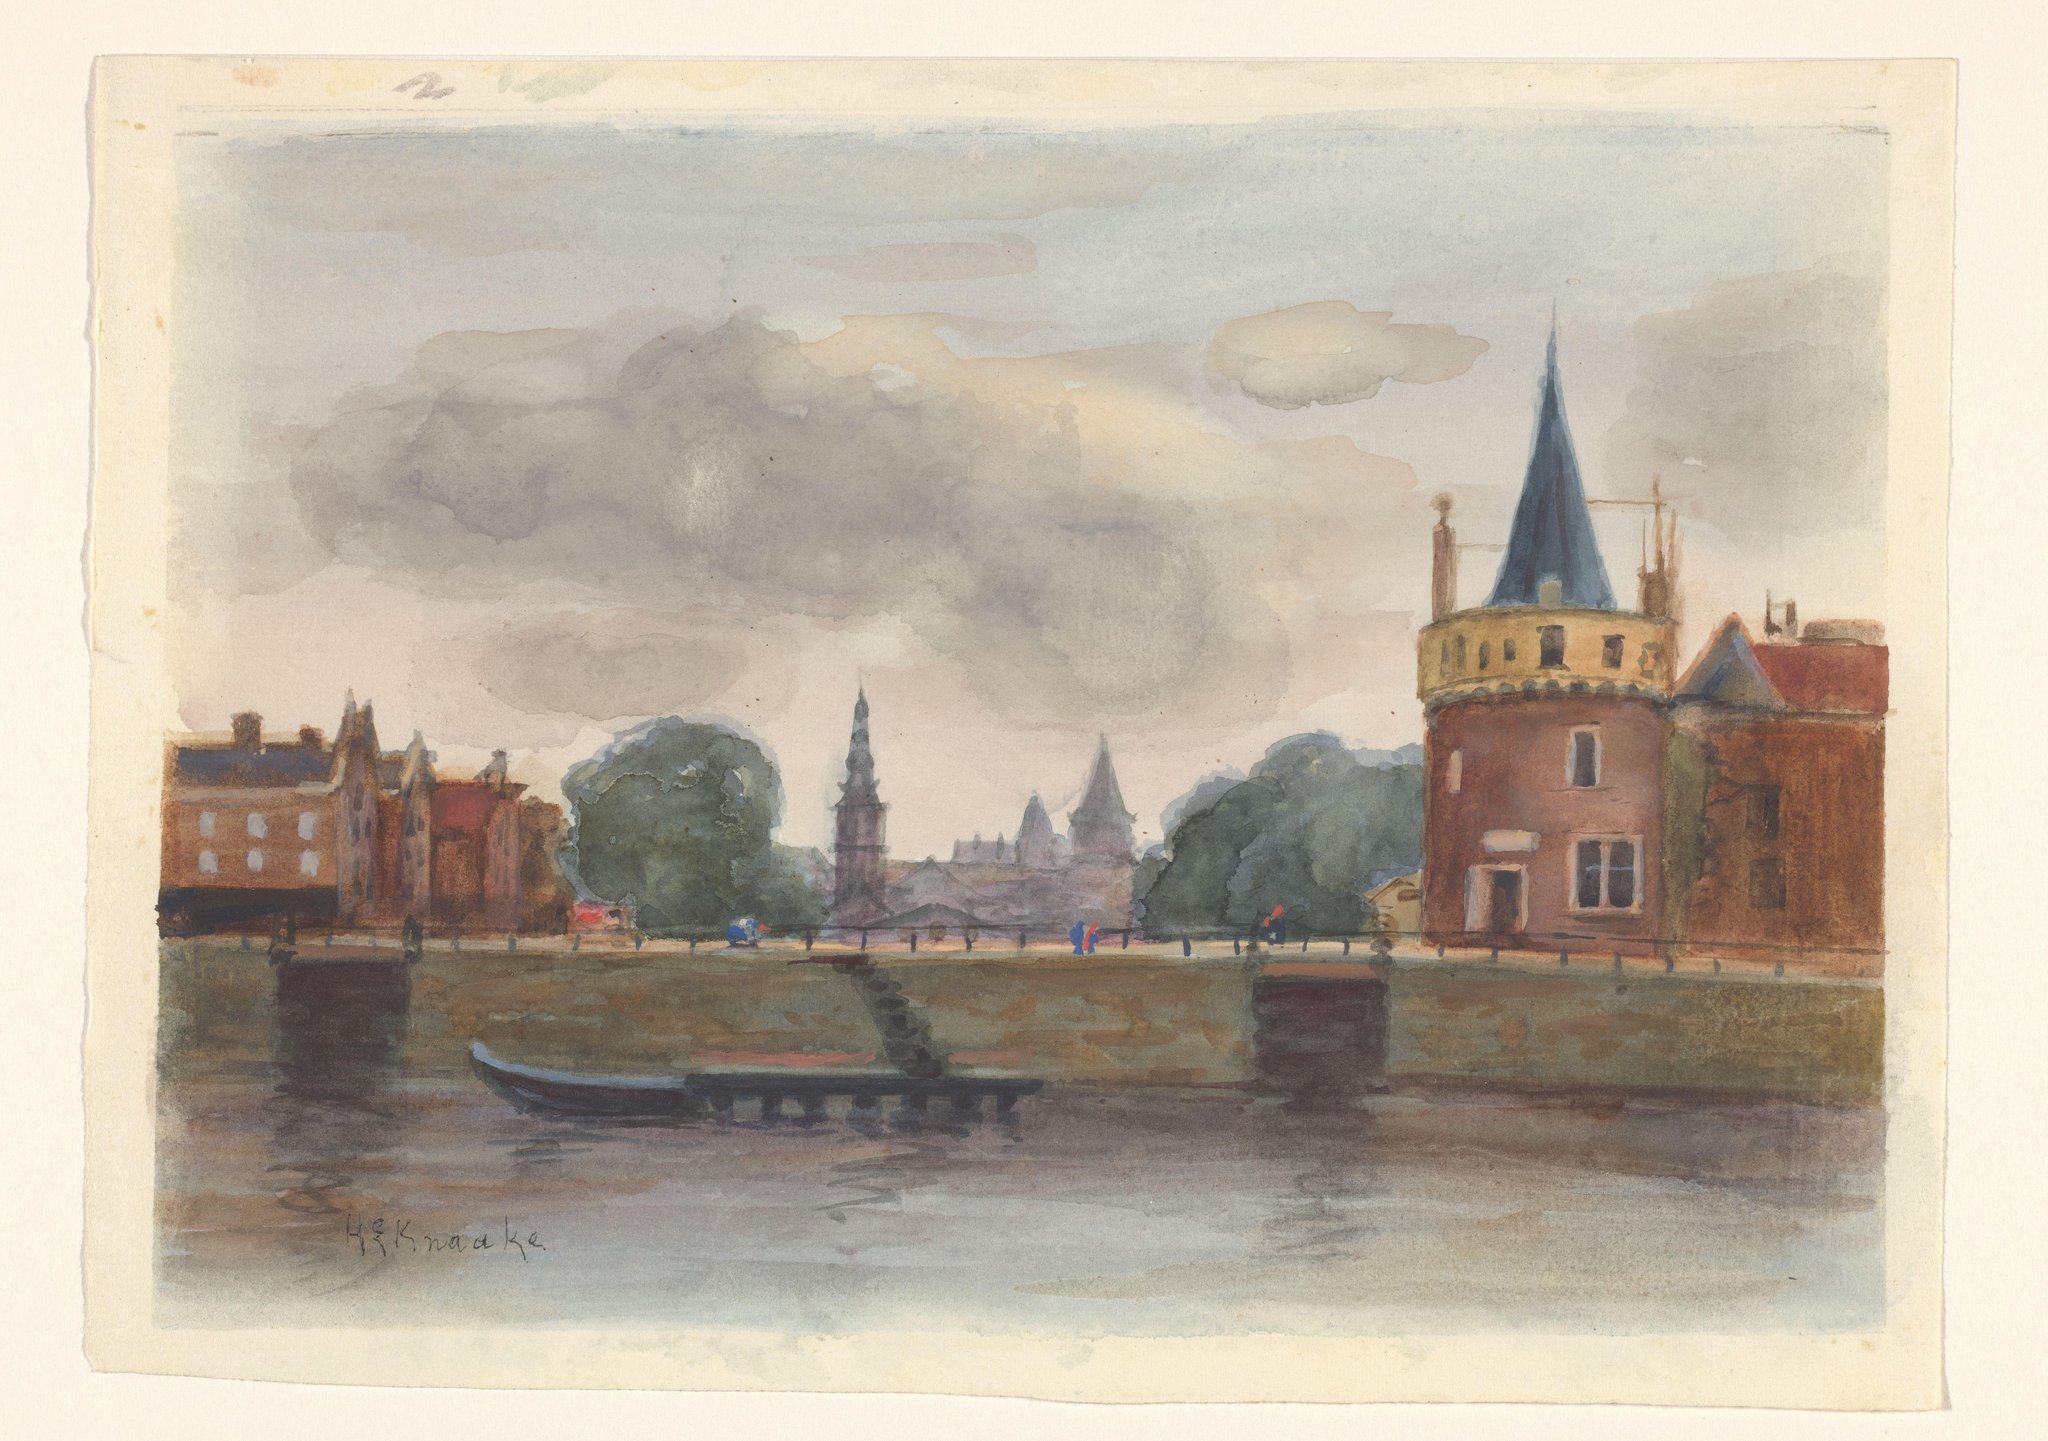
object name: drawing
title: Gezicht op de Schreierstoren te Amsterdam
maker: herman eduard knaake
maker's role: draughtsman, print maker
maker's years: 1863-1948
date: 1873-1938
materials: paper, watercolor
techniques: brush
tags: towers ~ fortified city, city-view, and landscape with man-made constructions (+ city(-scape) with figures, staffage)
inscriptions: inscription: ‘Geschenk C.H. Knaake/ te Zelhem’, inscription: ‘Wath[...]ar’